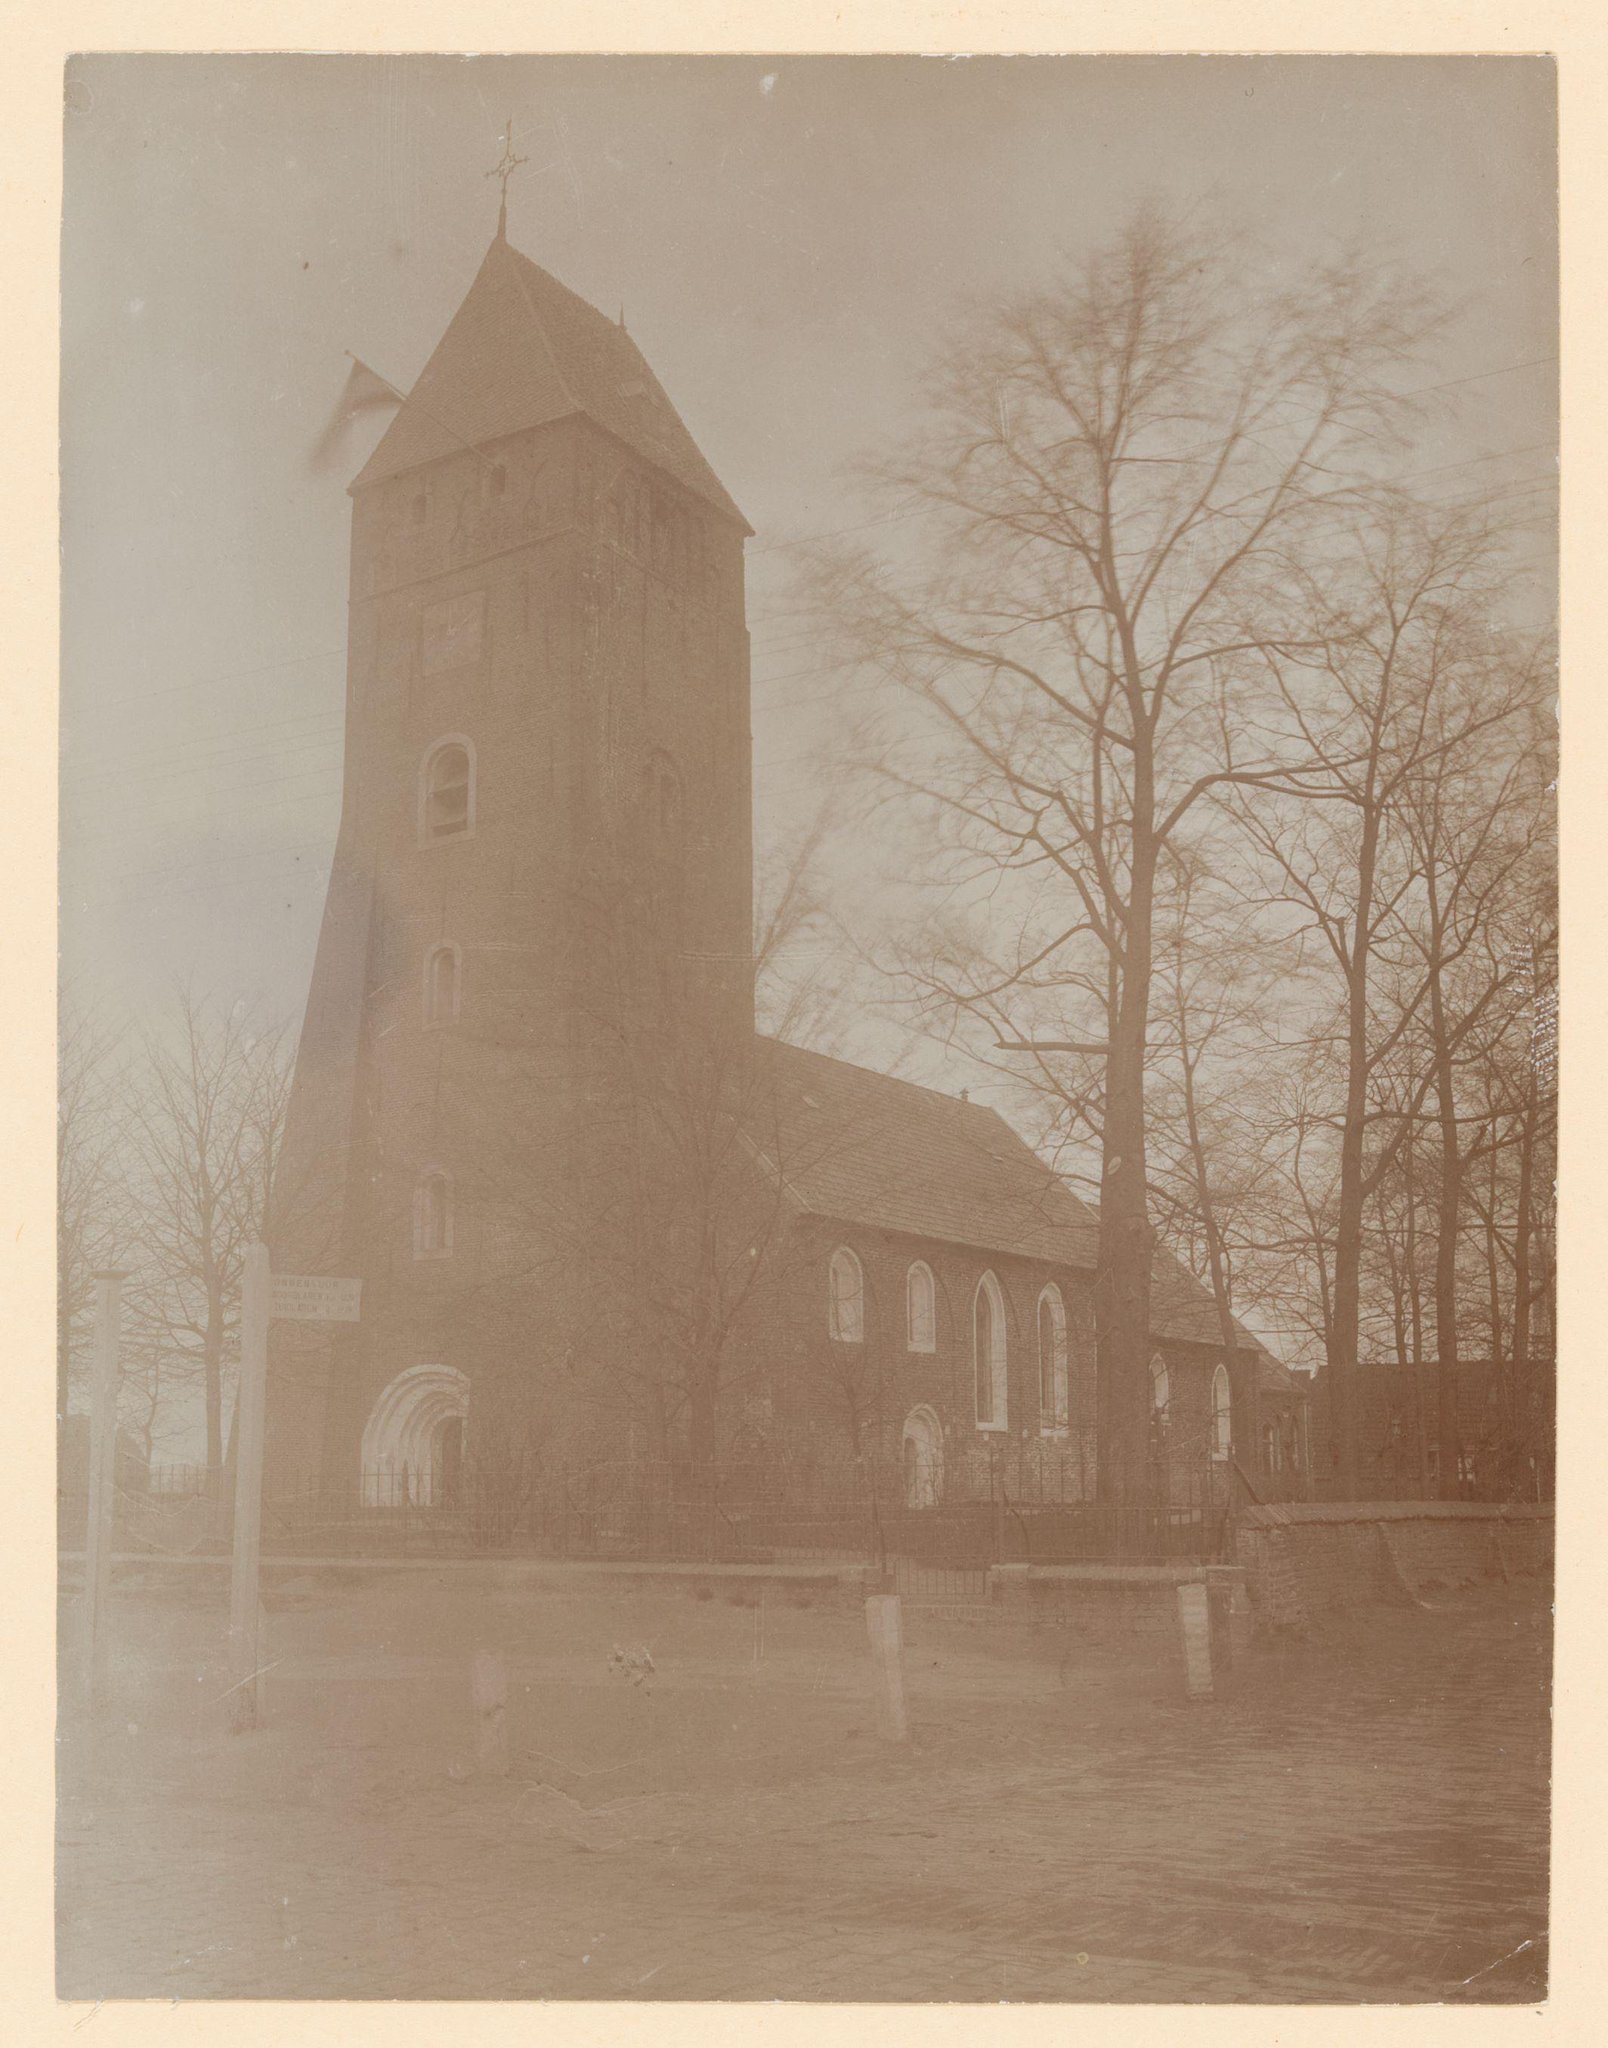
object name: photograph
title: Gezicht op de Hervormde Kerk te Haren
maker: anoniem (monumentenzorg)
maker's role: fotograaf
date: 1911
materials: cardboard, photographic support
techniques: collodion silver print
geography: haren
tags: church (exterior)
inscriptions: annotation: ‘Haren Gr. N.H. kerk April 1911’, annotation: ‘kerk te Haren/ april 1911/ Haren’